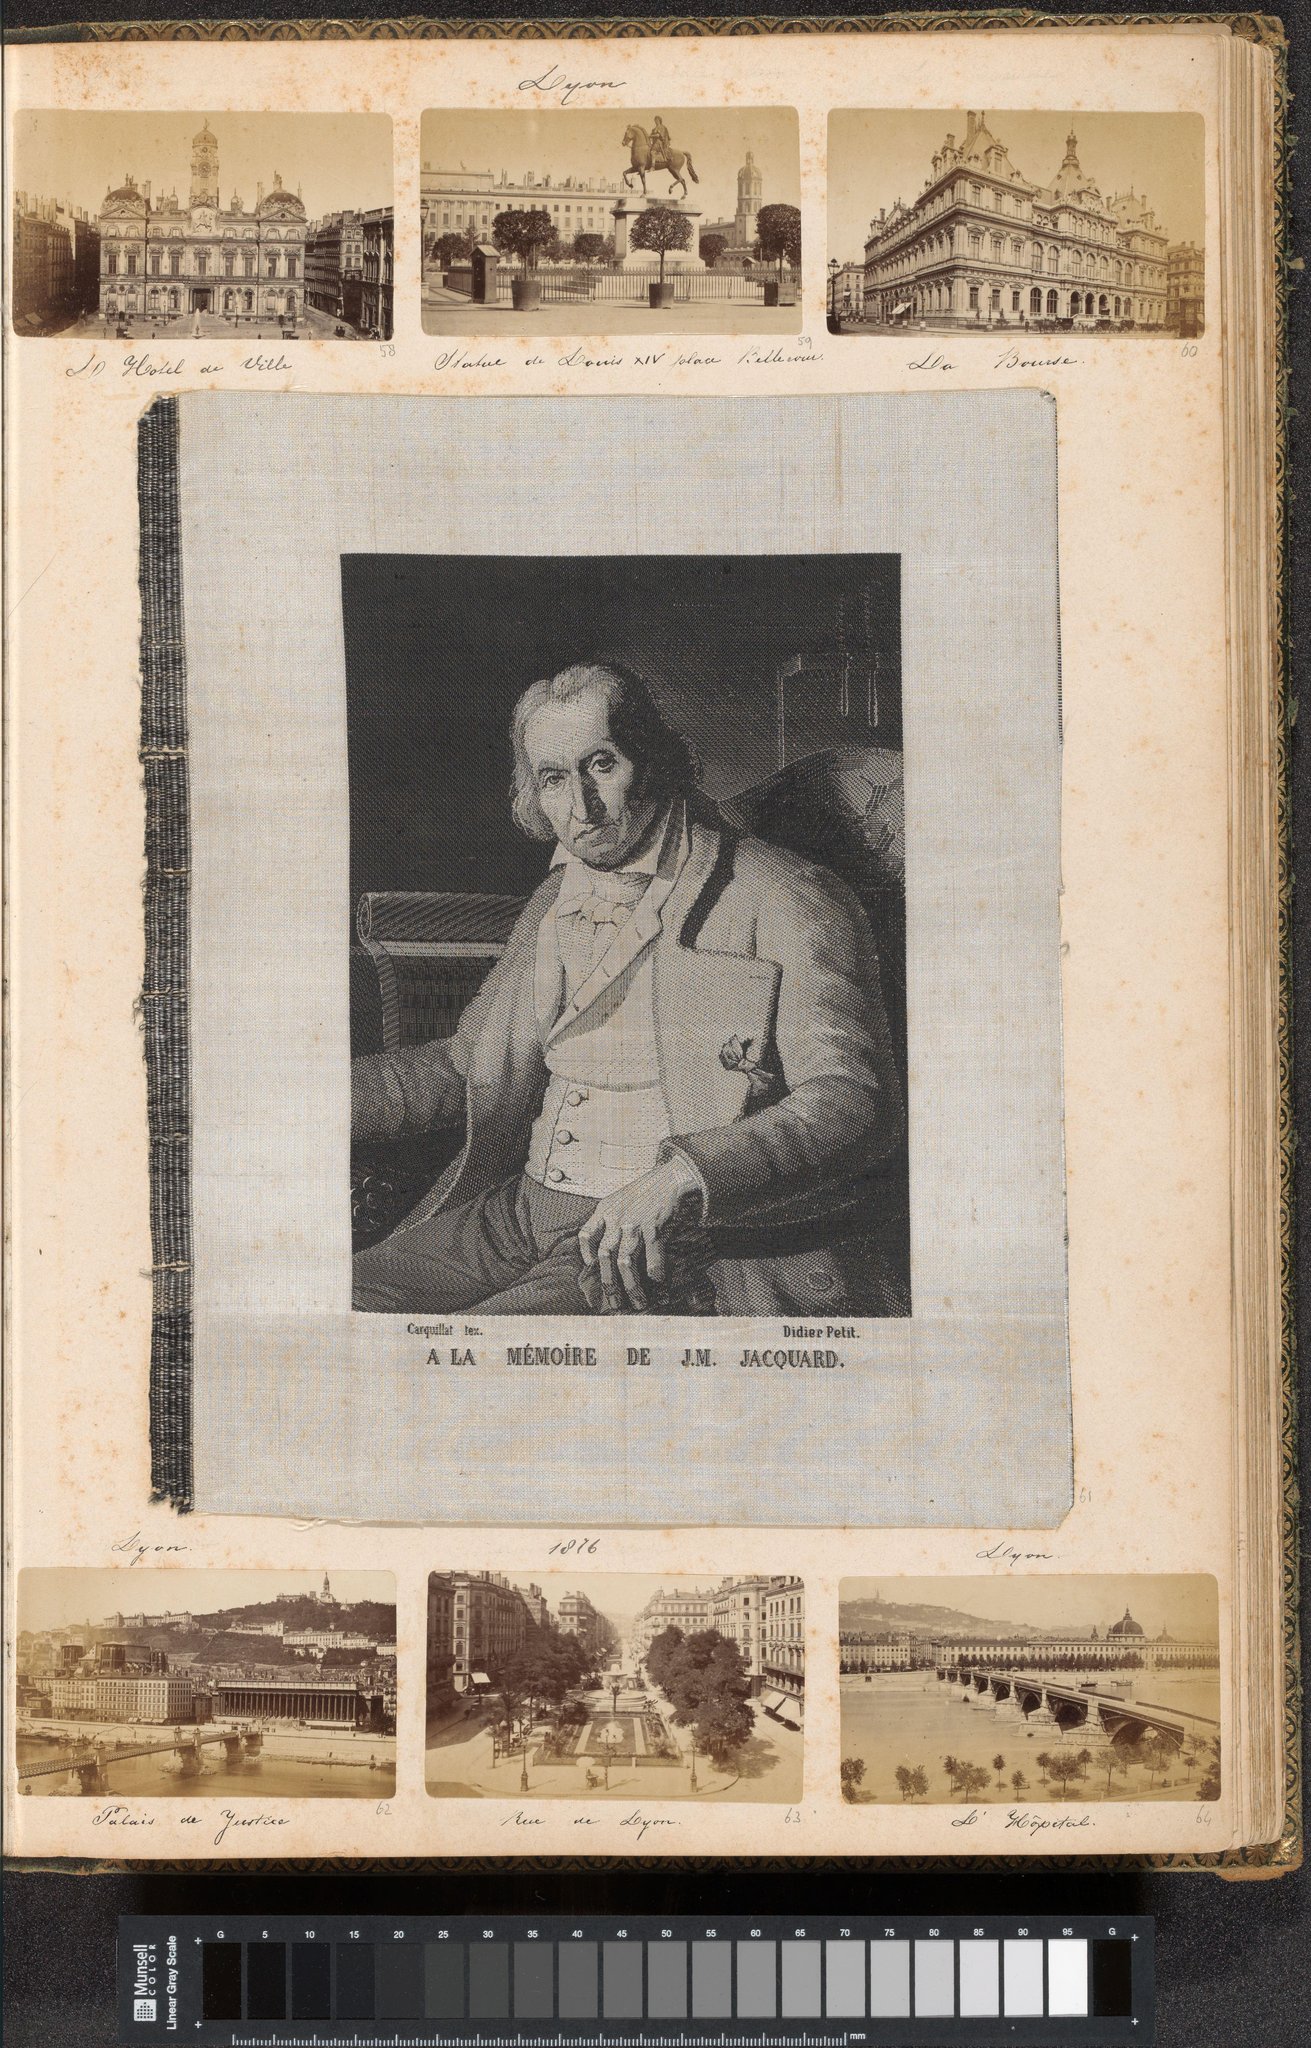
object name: woven material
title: Geweven portret van wever en handelaar J.M. Jacquard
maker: françois carquillat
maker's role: wever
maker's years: 1803-1884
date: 1870-1880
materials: silk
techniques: weave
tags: lyon, joseph marie jacquard, adult man, craftsman ~ applied arts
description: Onderdeel van Fotoalbum van Robert Daniel Crommelin (1841-1907).